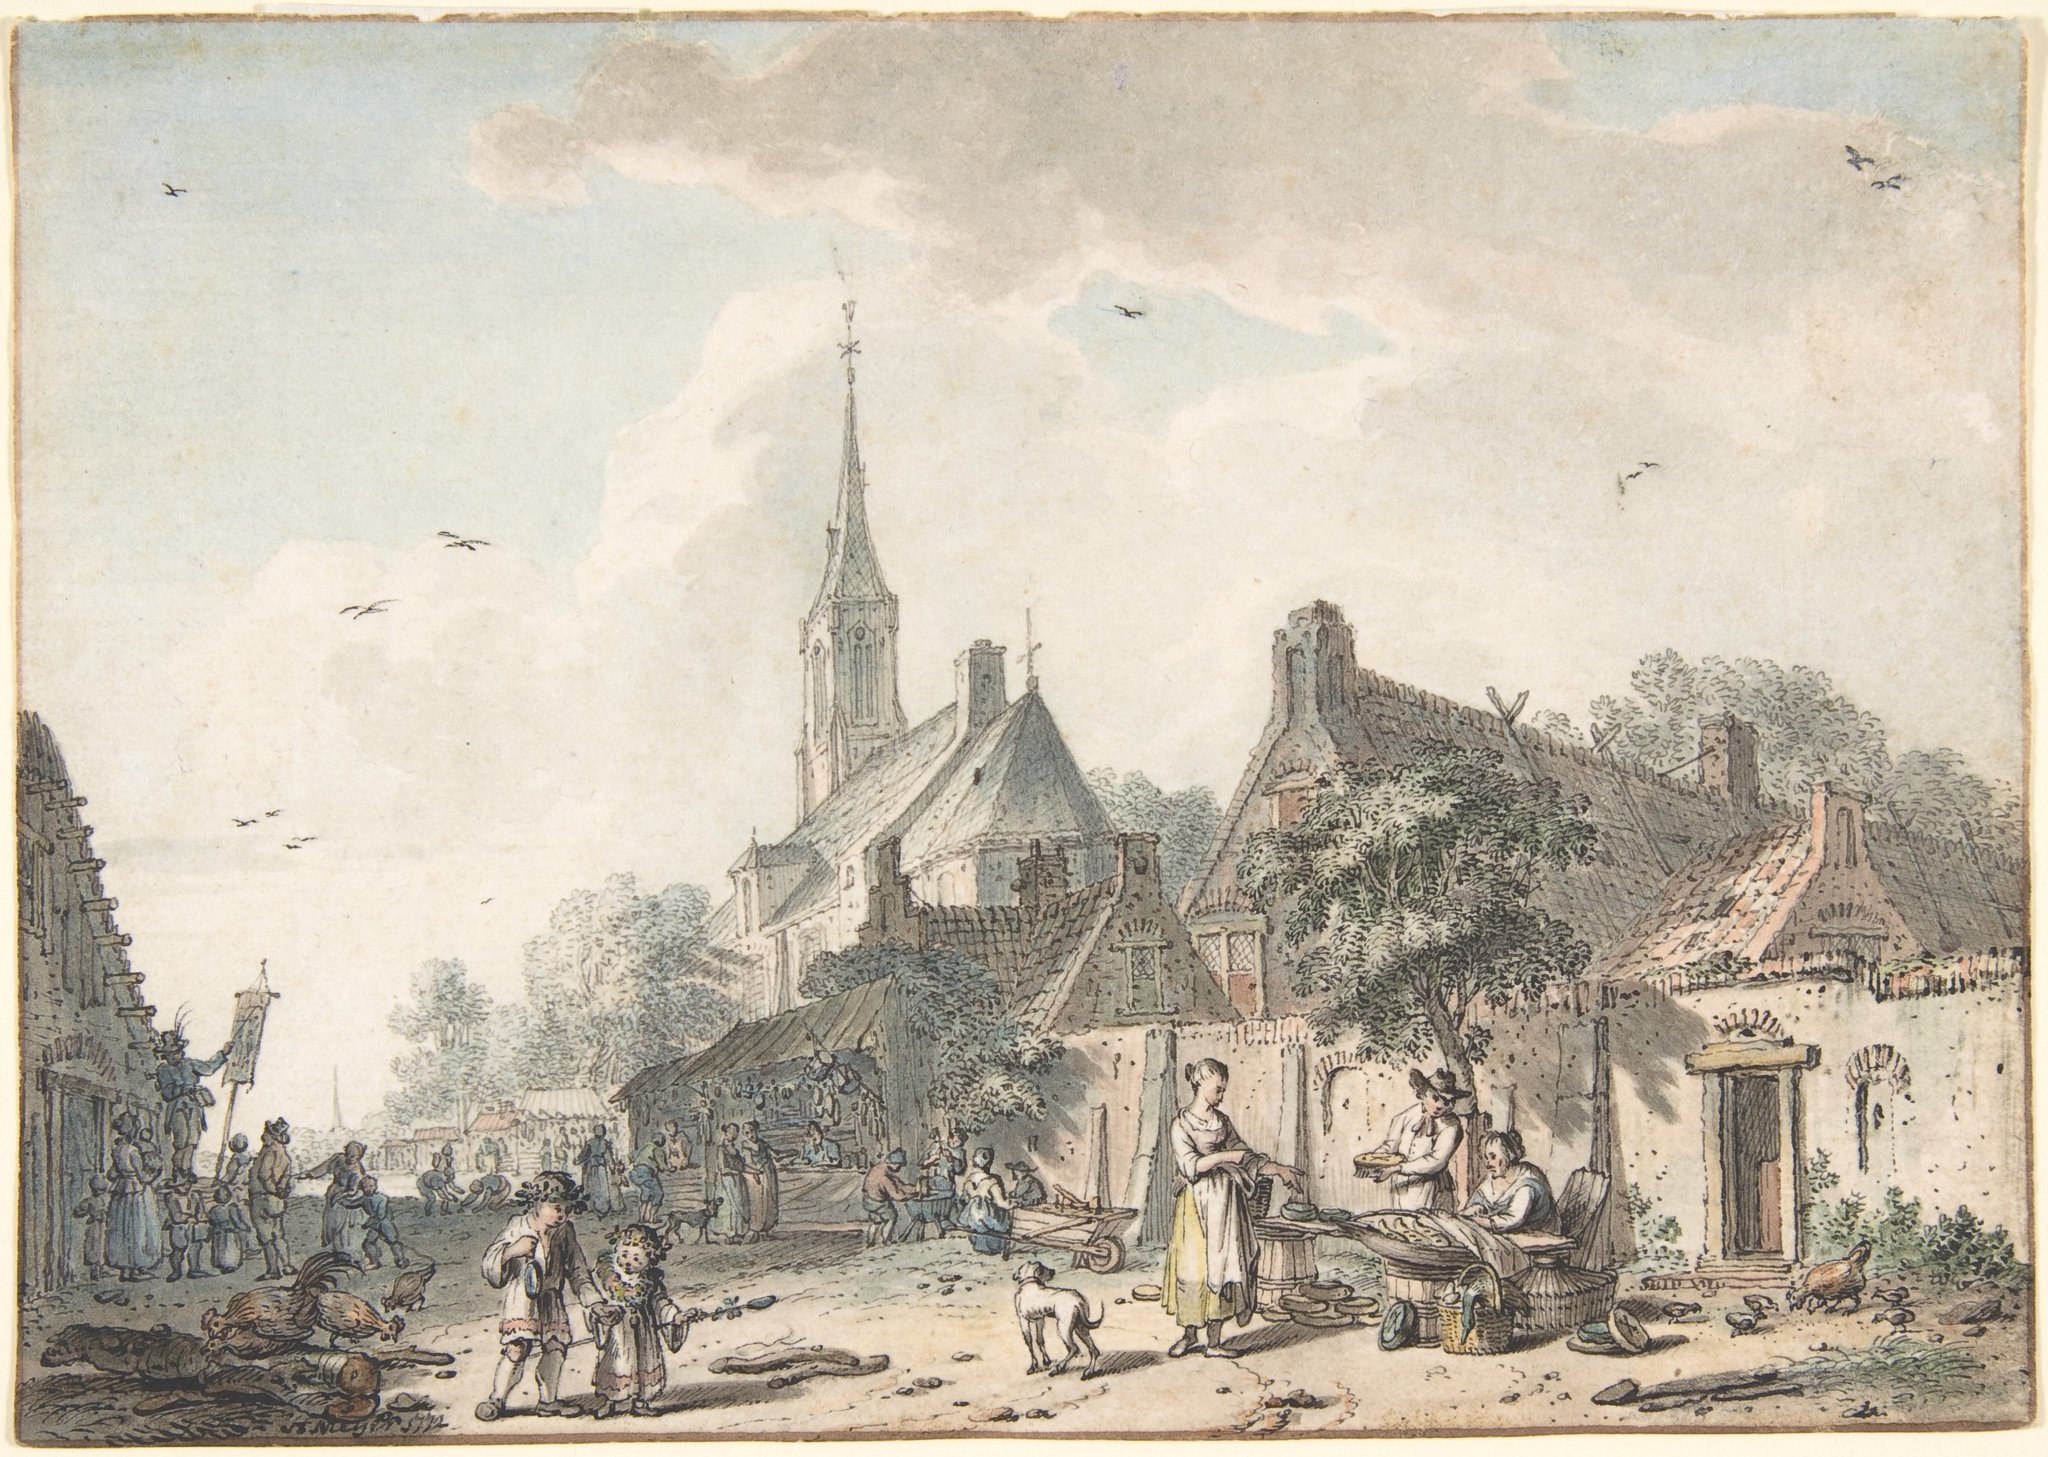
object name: drawing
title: May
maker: hendrik meijer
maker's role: artist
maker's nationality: dutch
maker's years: 1744-1793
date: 1772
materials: chalk, ink, watercolor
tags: towns,children,men,women,roosters,dogs,daily life